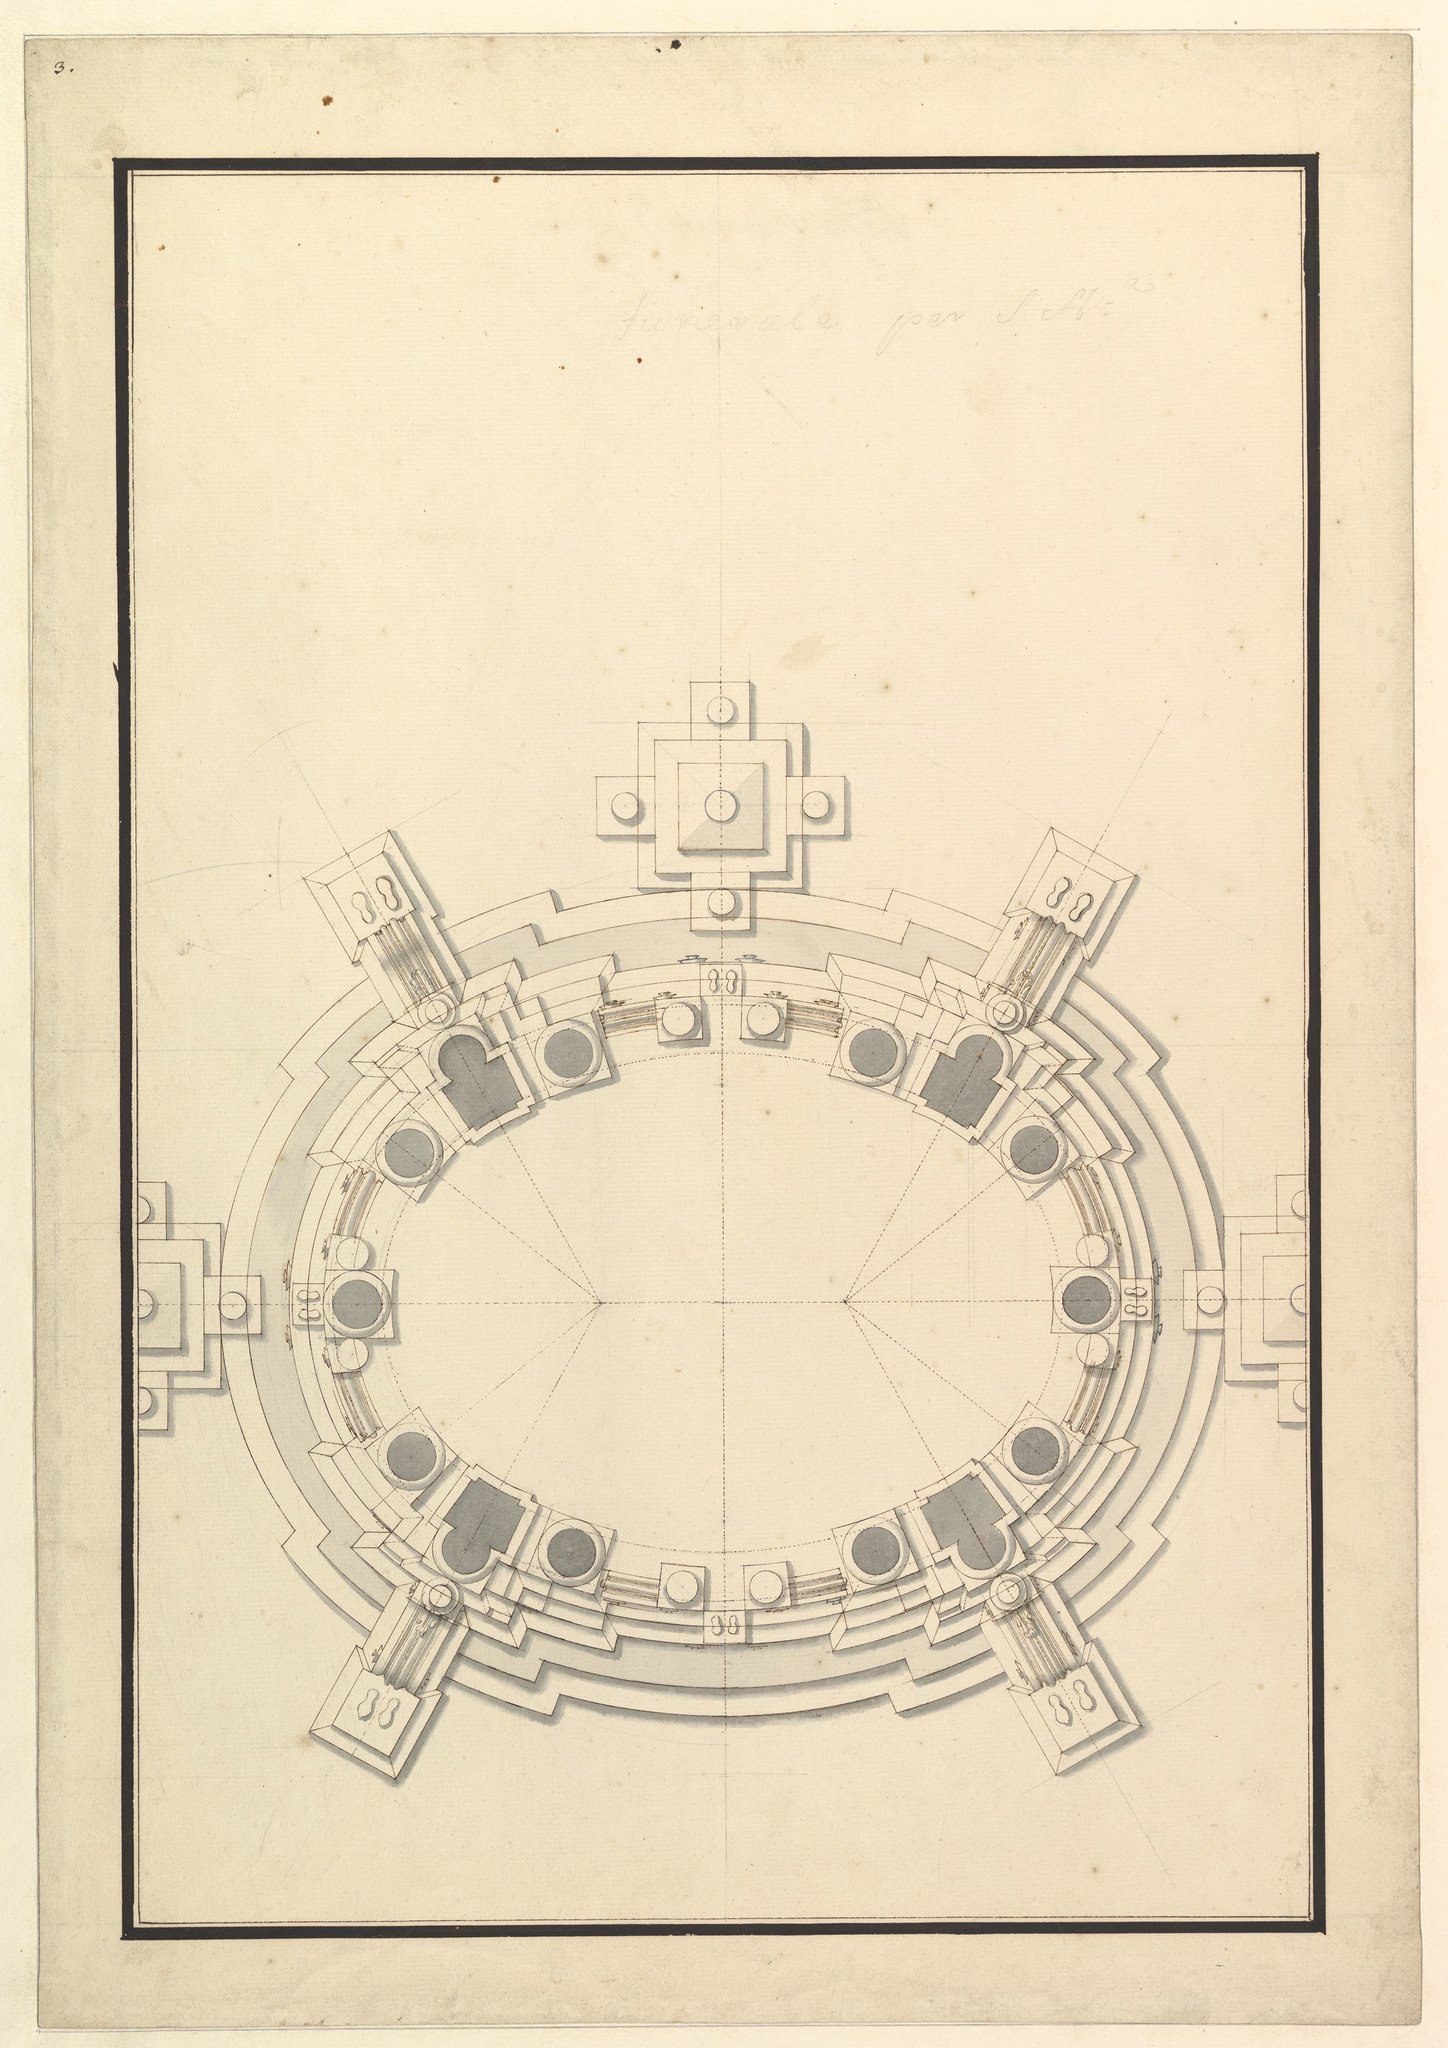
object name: drawing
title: Ground Plan for a Catafalque for a Prince of Lorraine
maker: giuseppe galli bibiena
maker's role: artist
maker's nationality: italian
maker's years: 1696-1756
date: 1696-1756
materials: chalk, ink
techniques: pen, wash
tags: architecture